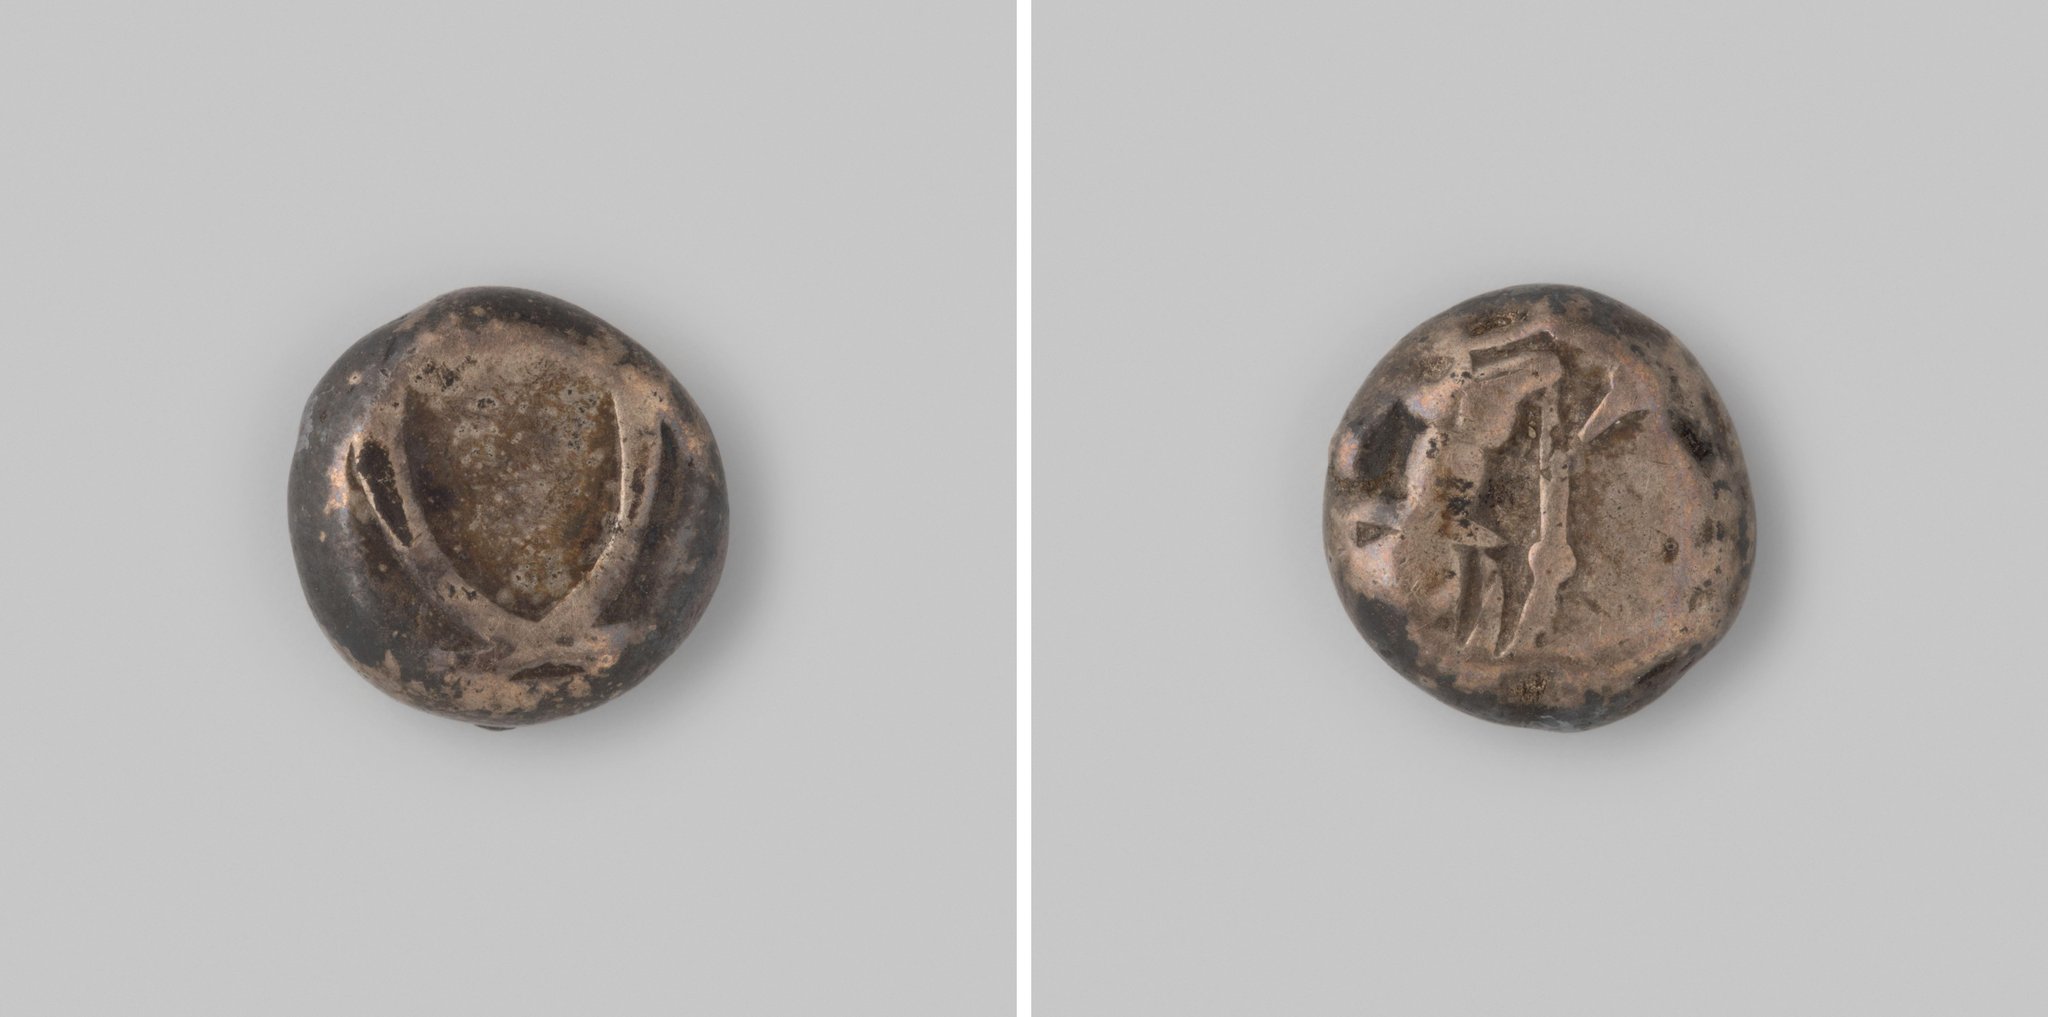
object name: coin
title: Zilveren dubbele fanam uit Madras in Brits Indië onder de East India Company,1764-1807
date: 1764-1807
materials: silver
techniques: striking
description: Zilveren munt. Voorzijde: afbeelding van de Godheid Vishnu. Keerzijde: twee naar elkaar gewende en in elkaar verstrengelde letters C [=Company].